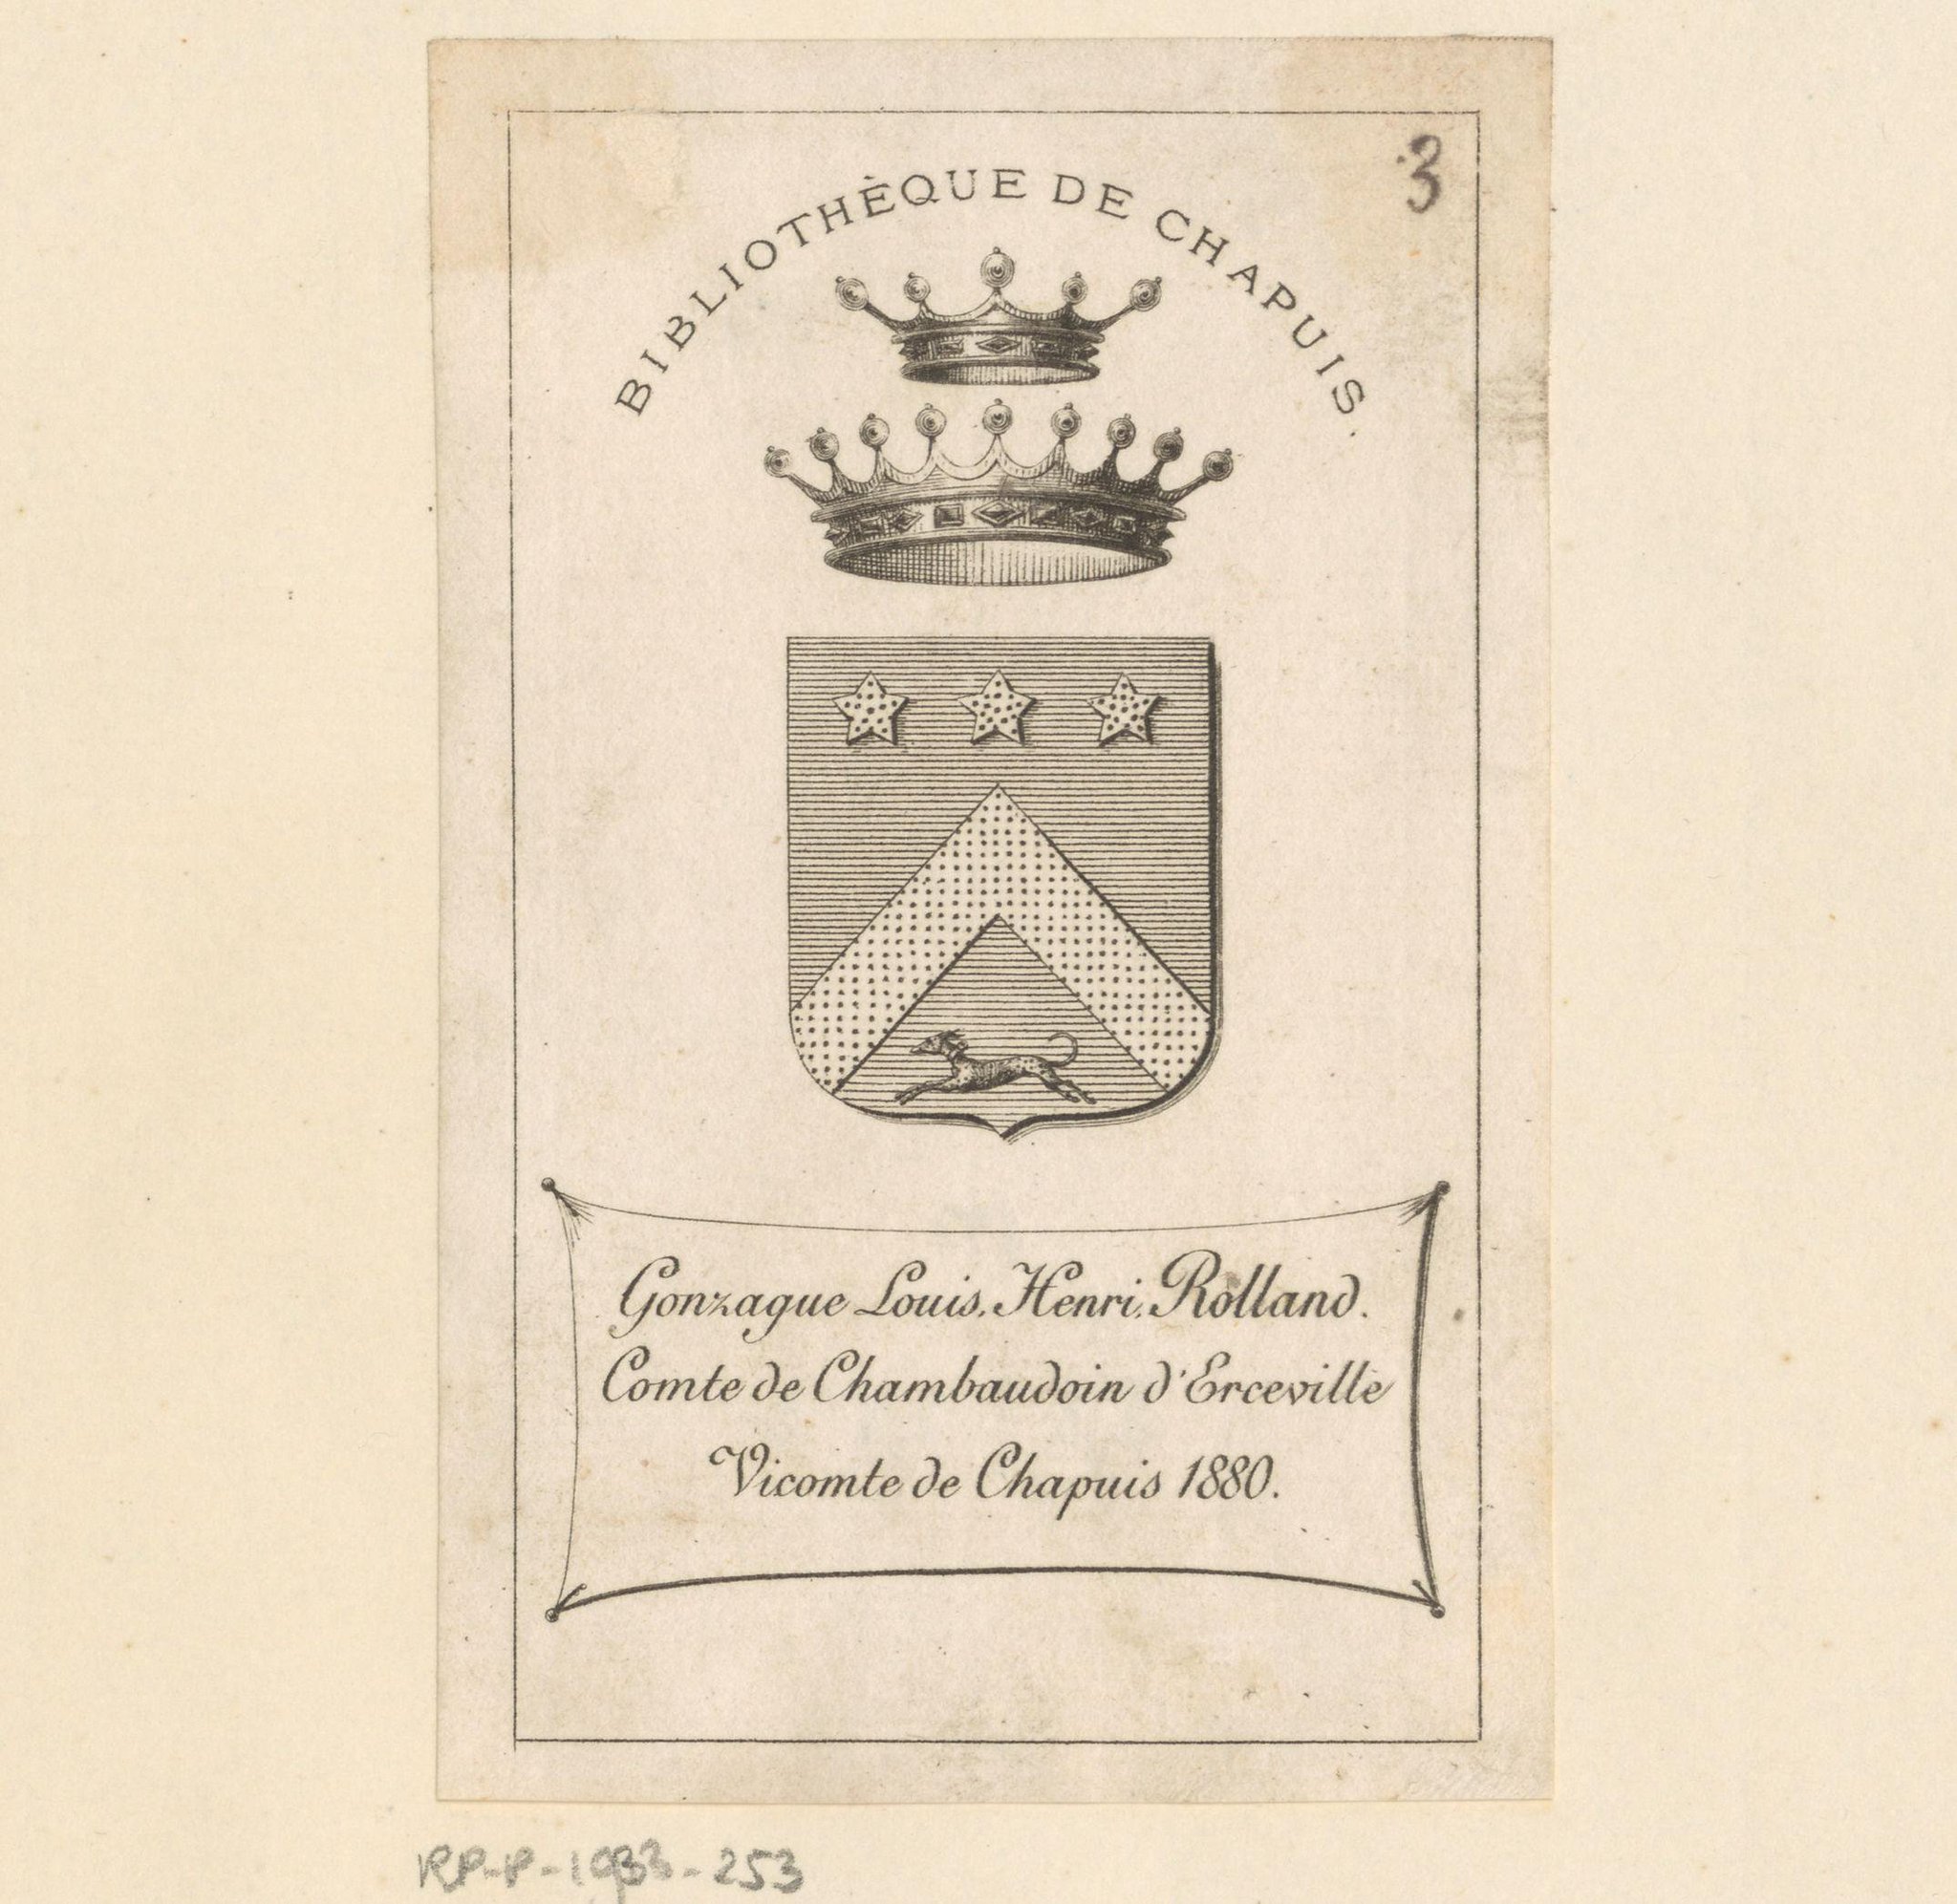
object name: bookplate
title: Ex libris van Gonzague Louis Henri Rolland graaf de Chambaudoin d'Erceville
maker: Anonymous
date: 1880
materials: paper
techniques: etching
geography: france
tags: armorial bearing, heraldry, dog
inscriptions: collector's mark: Lugt 2760